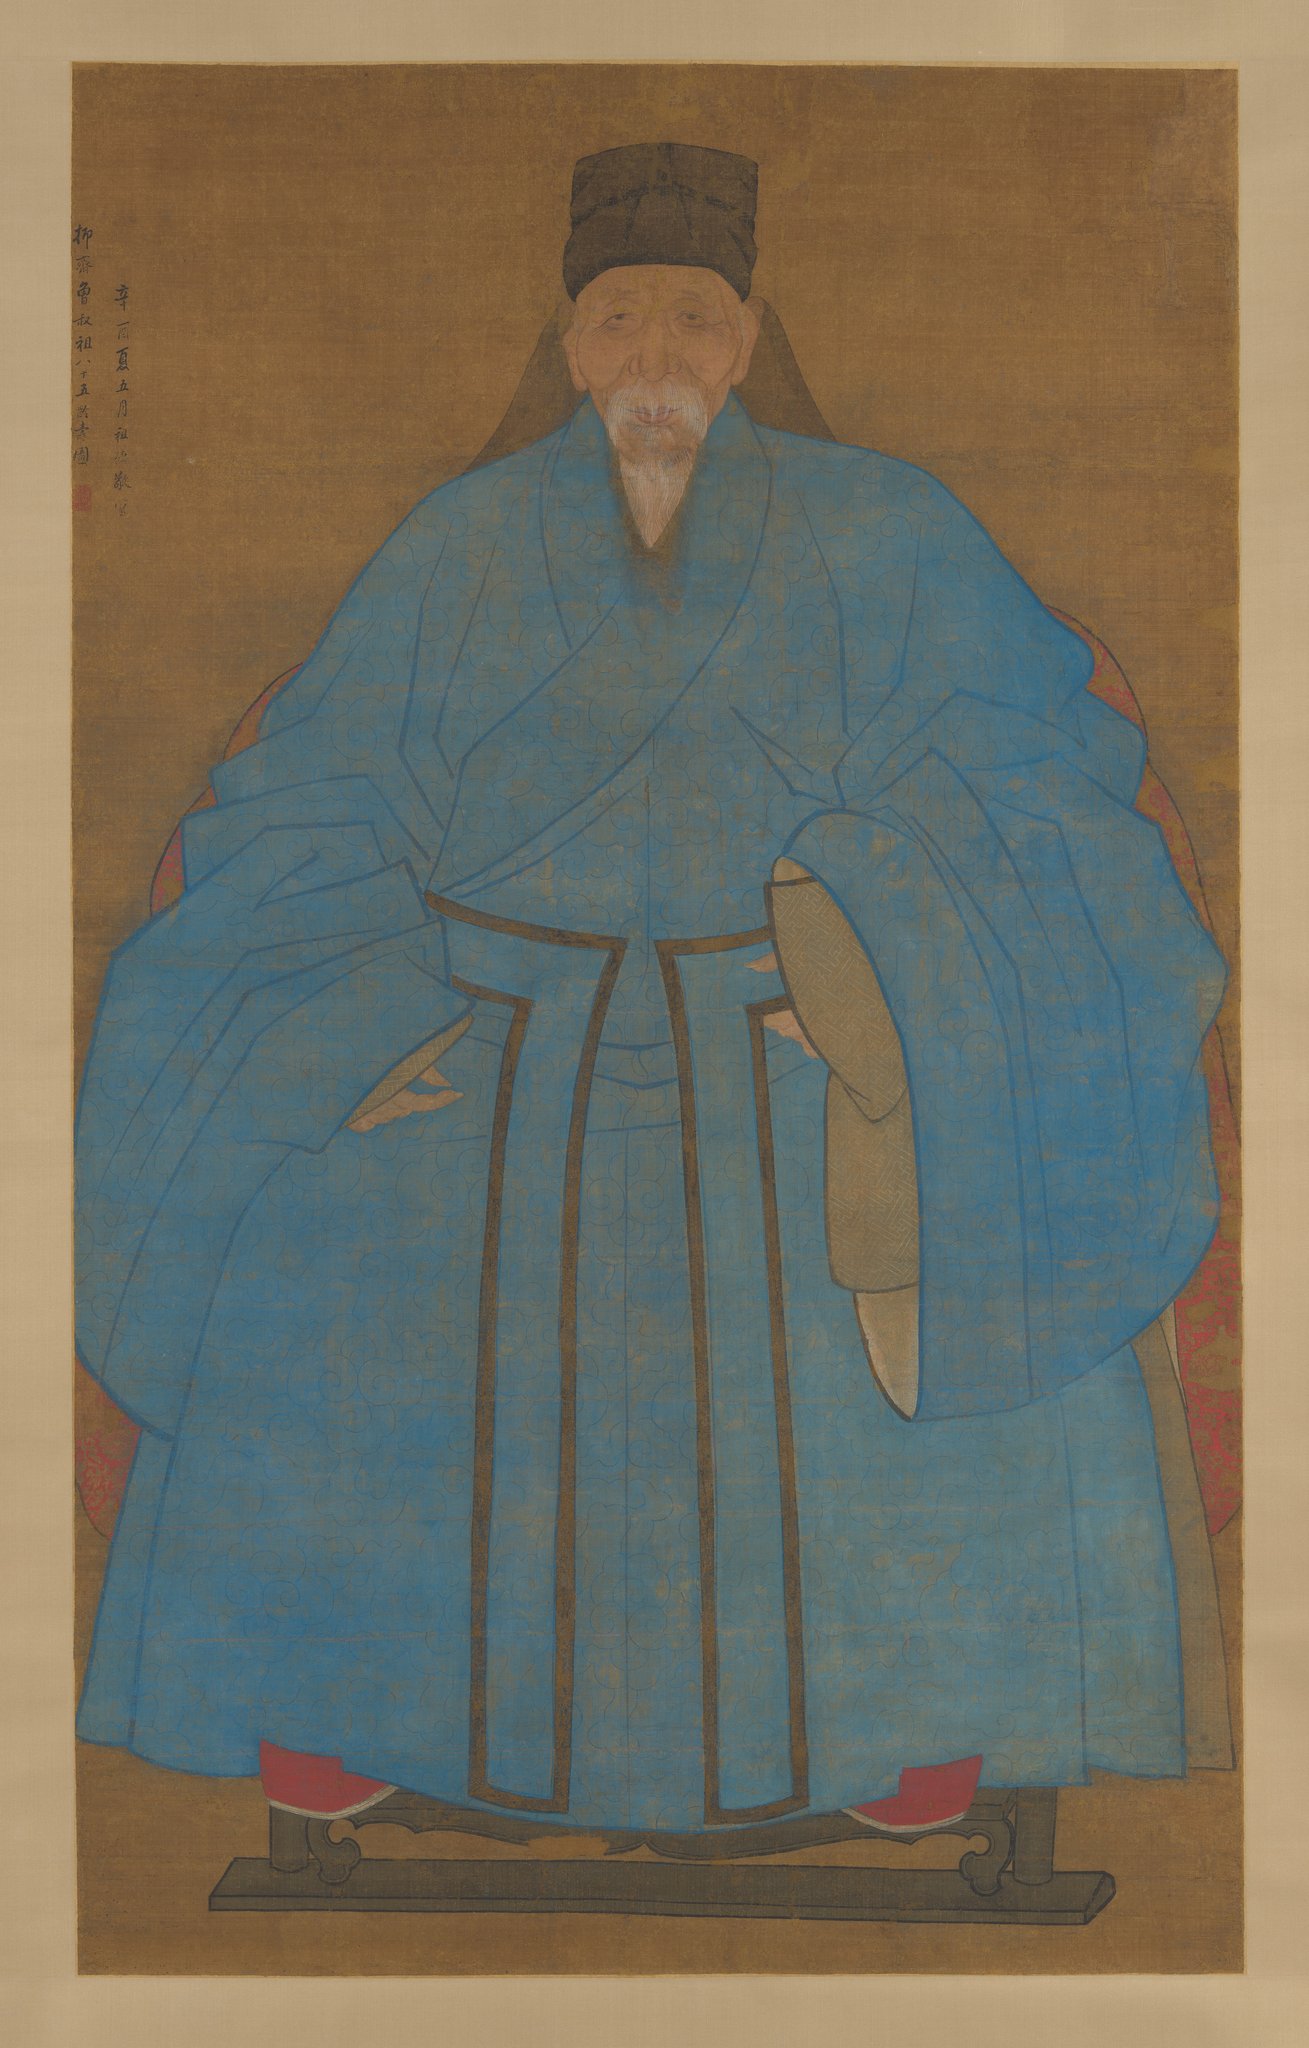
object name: hanging scroll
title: Portrait of the artist’s great-granduncle Yizhai at the age of eighty-five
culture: chinese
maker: ruan zude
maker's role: artist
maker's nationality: chinese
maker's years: 1500-1699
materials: ink, silk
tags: men,portraits